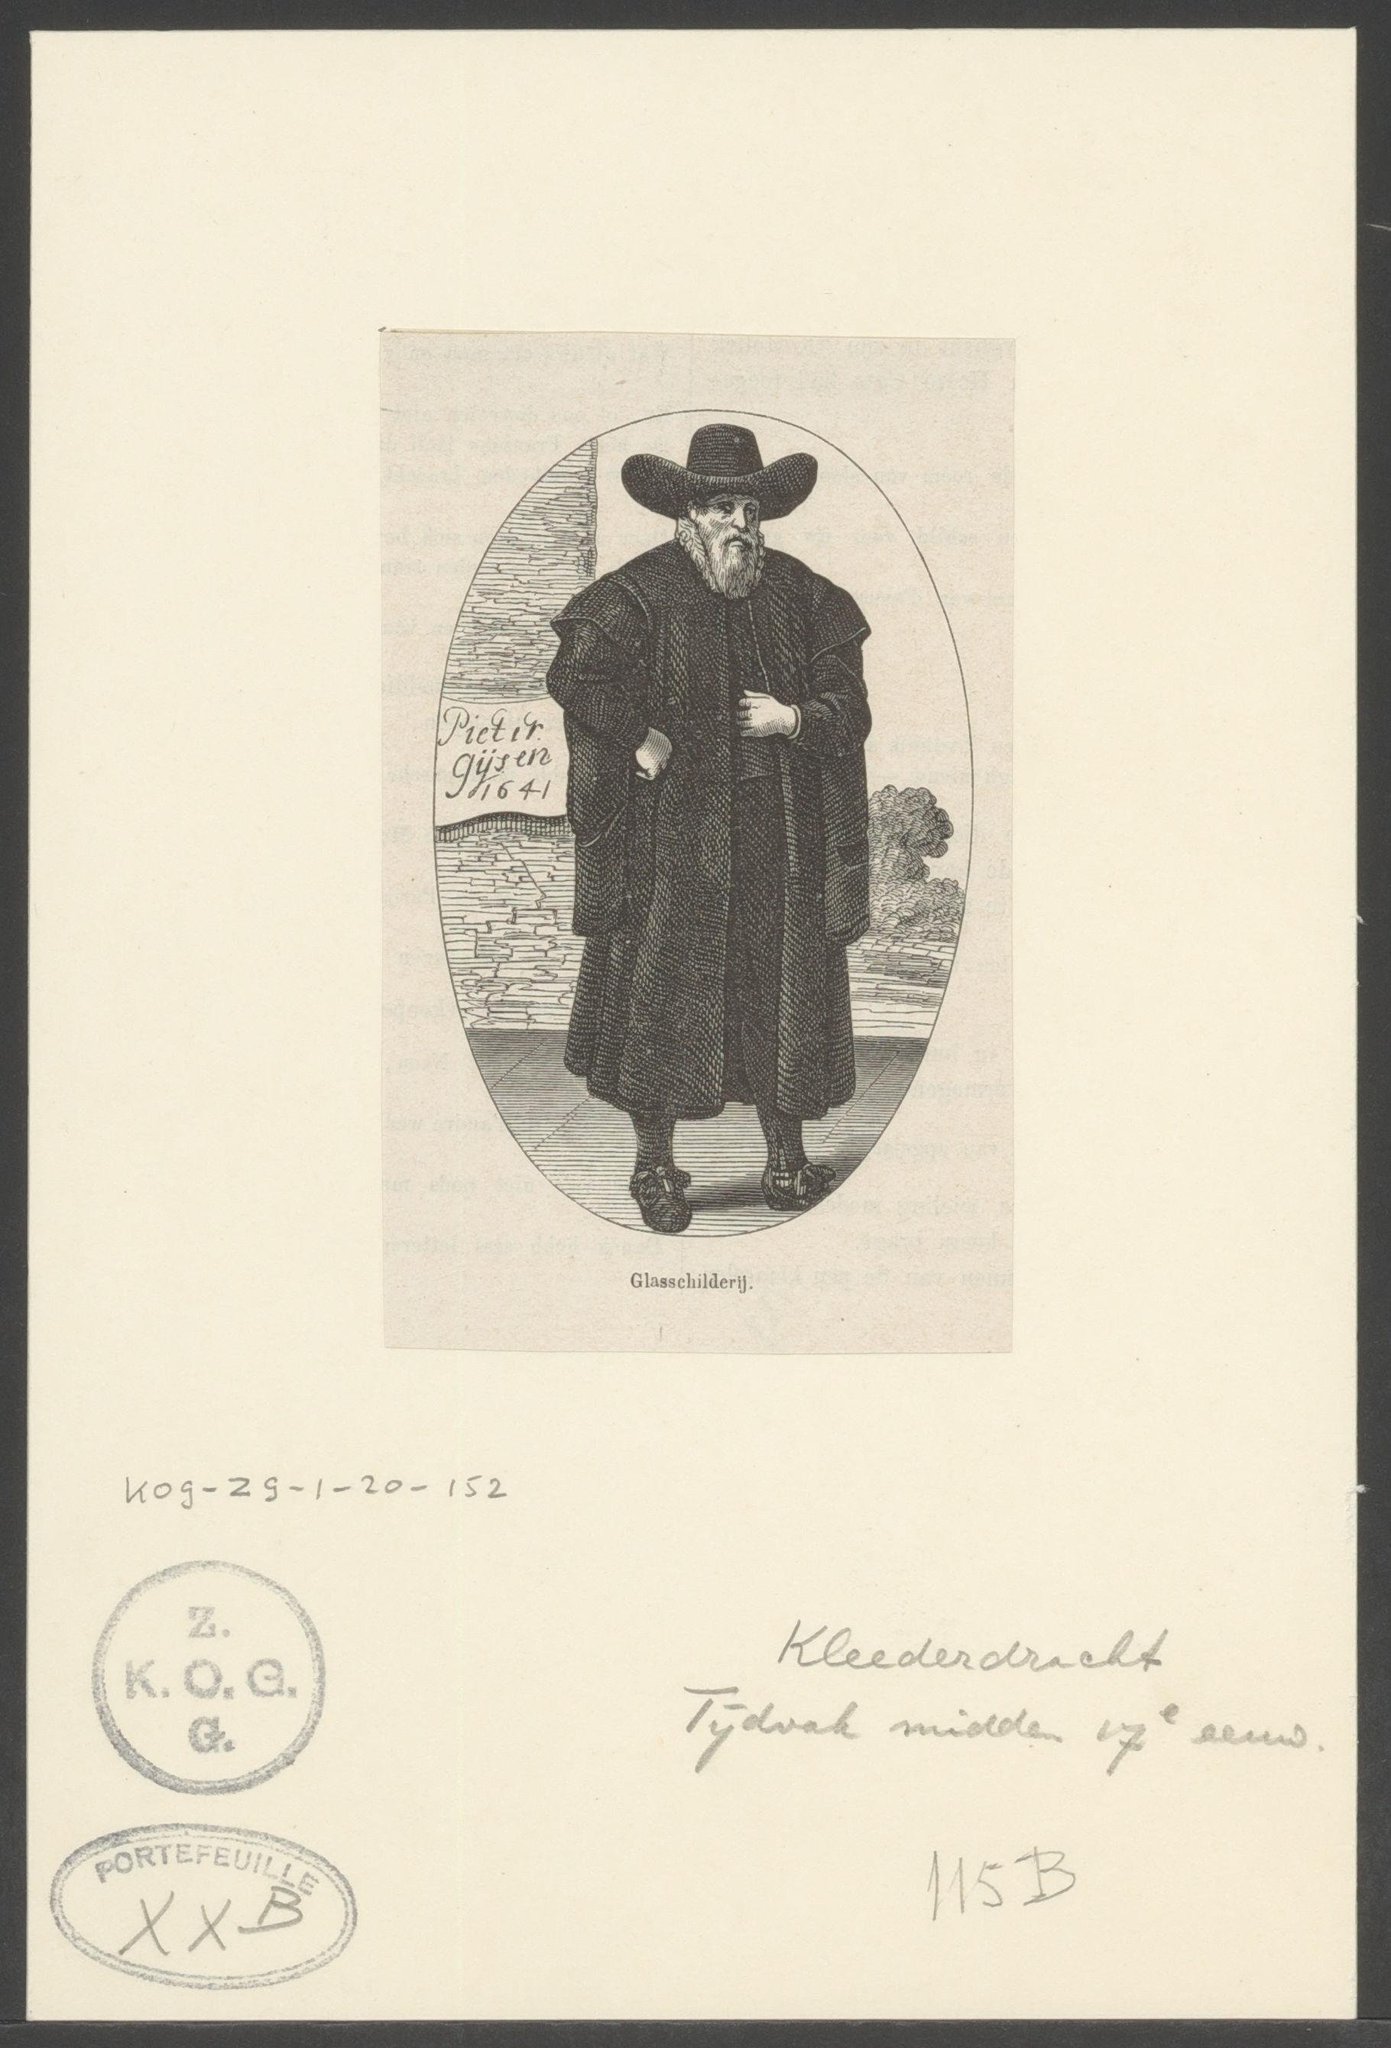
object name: print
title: Glasschilderij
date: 1869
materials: paper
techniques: letterpress printing, engraving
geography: haarlem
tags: standing figure, merchant, salesman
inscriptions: collector's mark: Lugt 1641, stamp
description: Onderwerpsrubrieken binnen de Atlas Zeden en Gewoonten: Zeden en Gewoonten in Engeren Zin, De Kleeding, Kleederdrachten (tijdvakken), Het midden der 17de eeuw. (De Fransche mode).